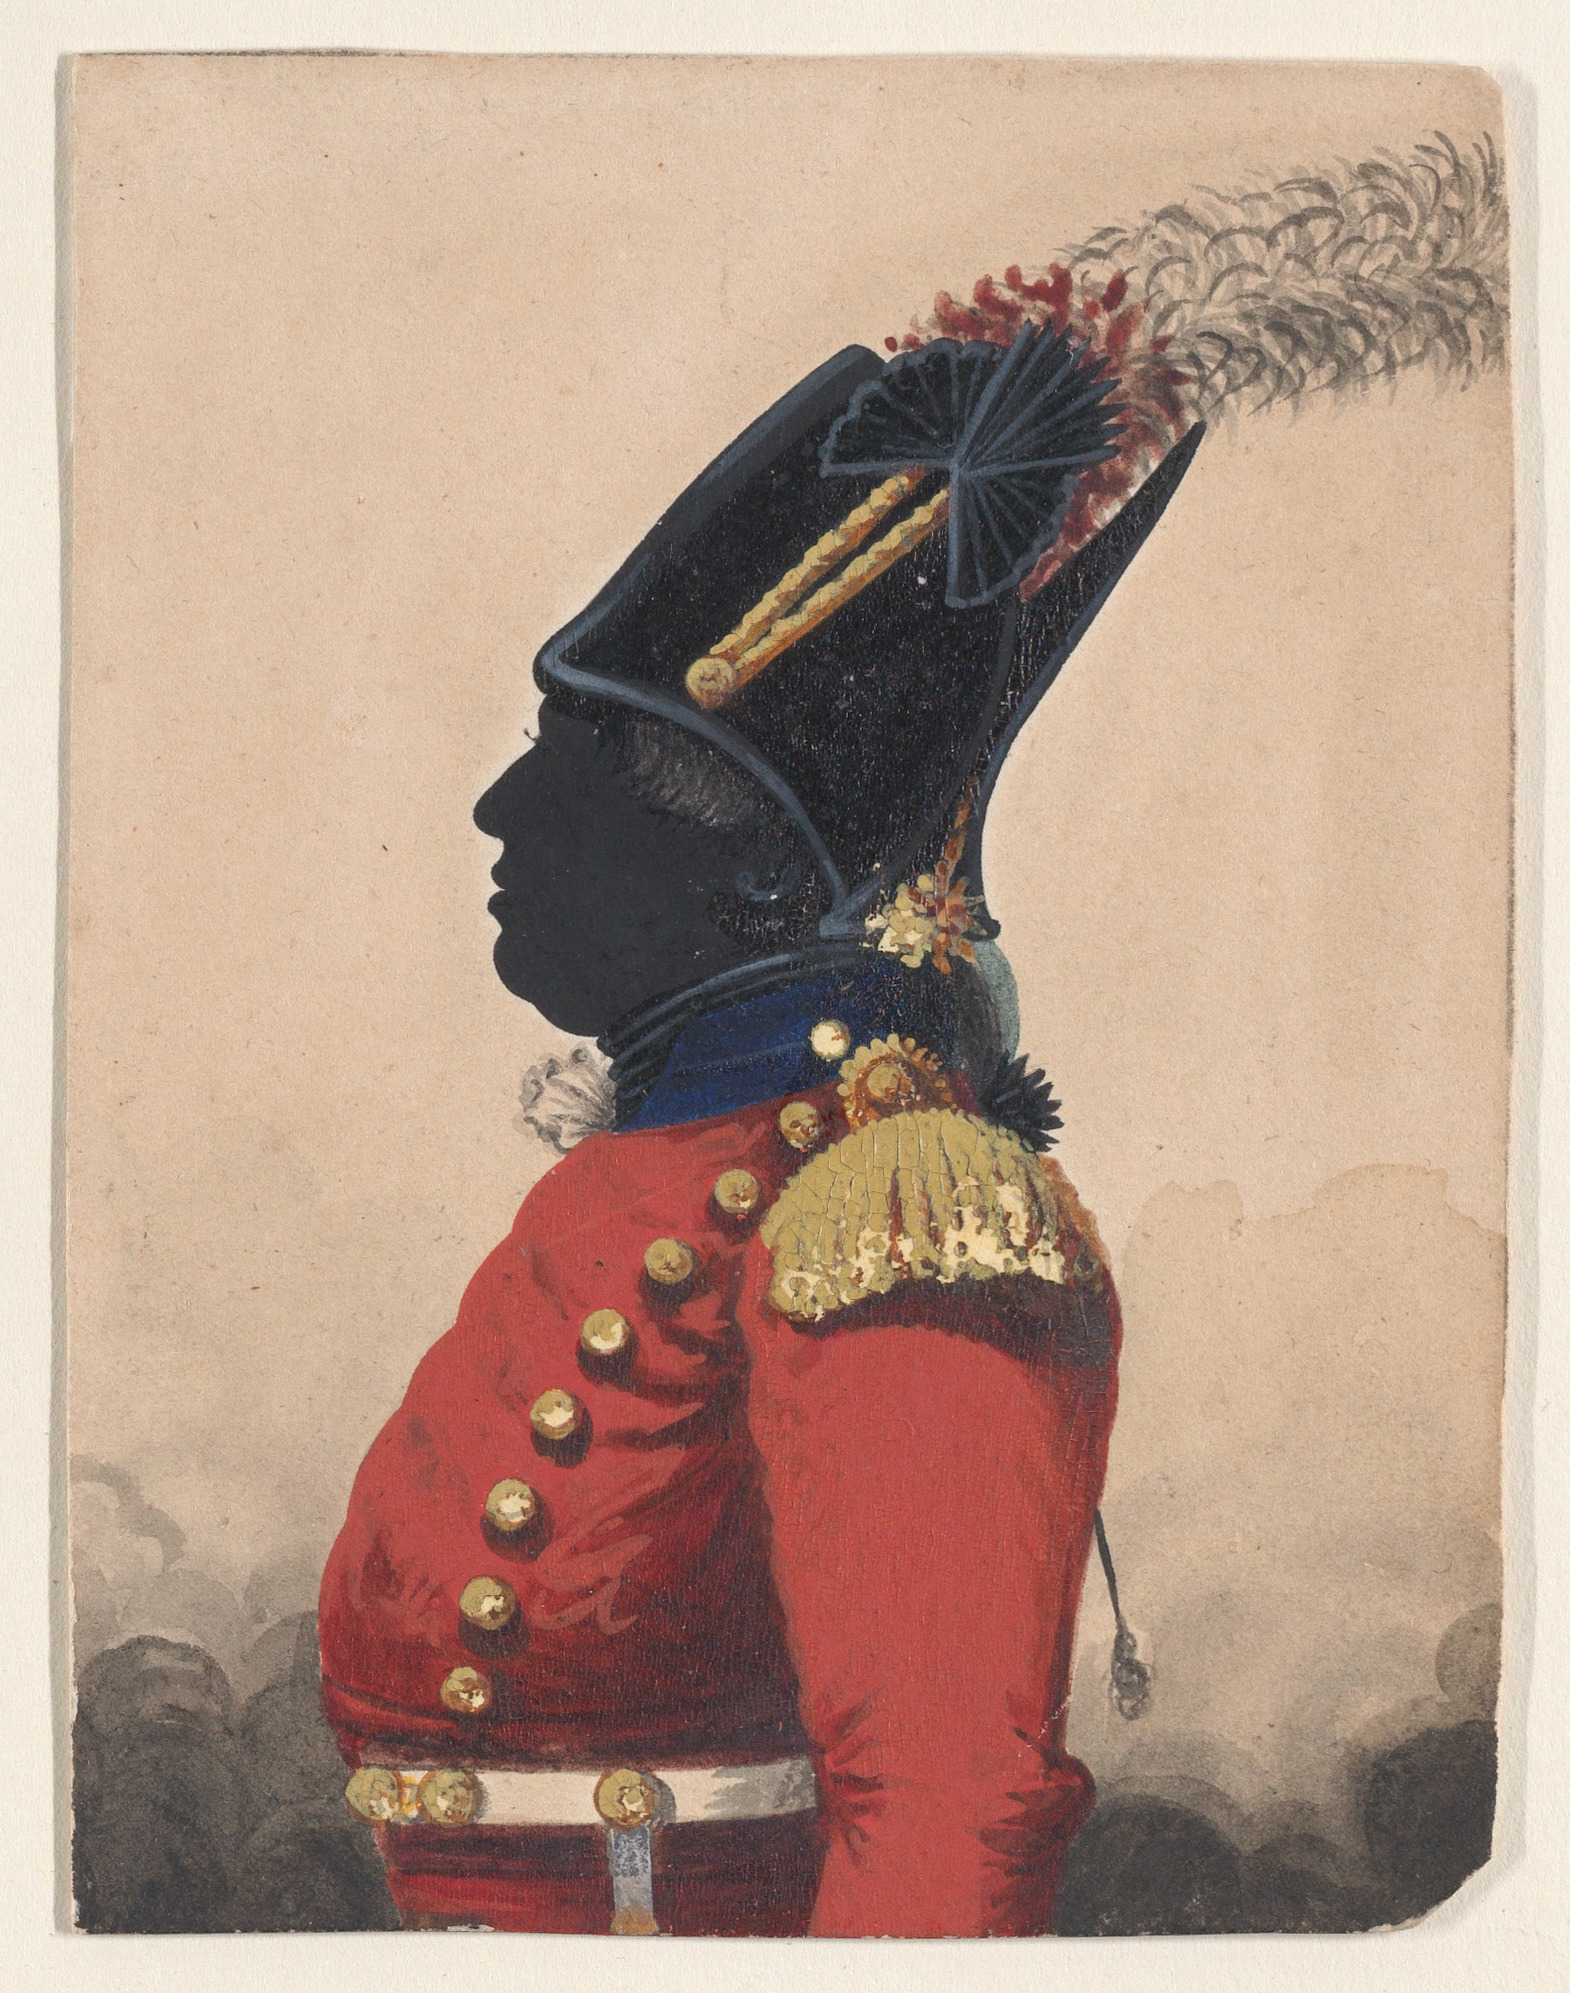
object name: drawing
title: Half-length silhouette of an officer with a feathered hat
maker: john buncombe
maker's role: artist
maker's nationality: british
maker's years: 1804-1904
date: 1825-1900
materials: gouache, ink, watercolor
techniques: pen